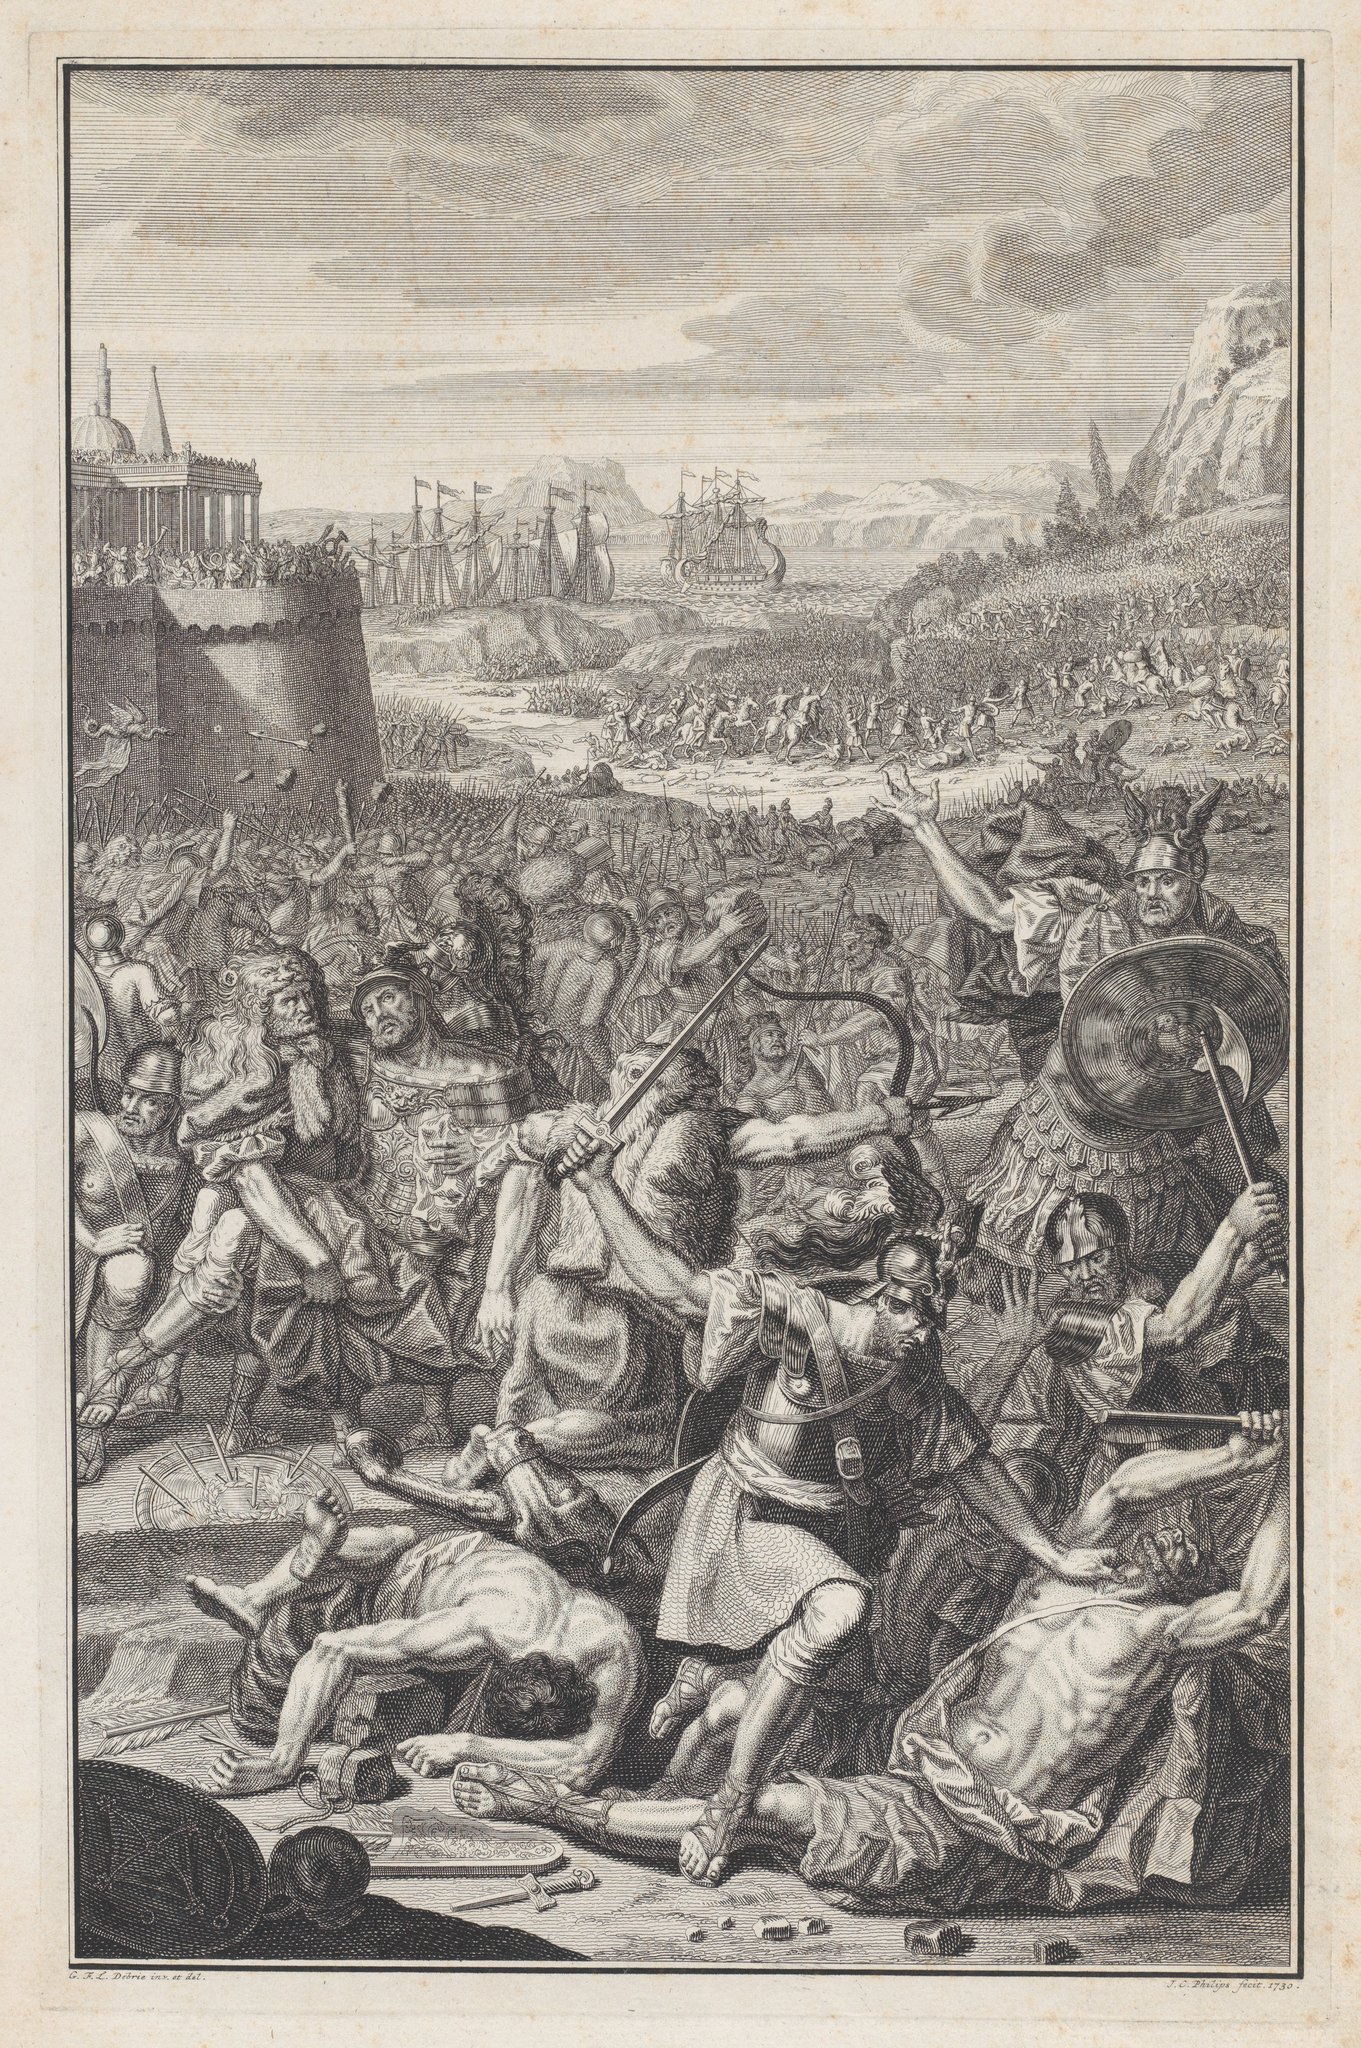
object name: print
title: Battle scene with a man about to be stabbed with a sword at lower right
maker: jan caspar philips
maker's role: artist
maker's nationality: dutch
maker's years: 1700-1775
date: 1730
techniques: etching